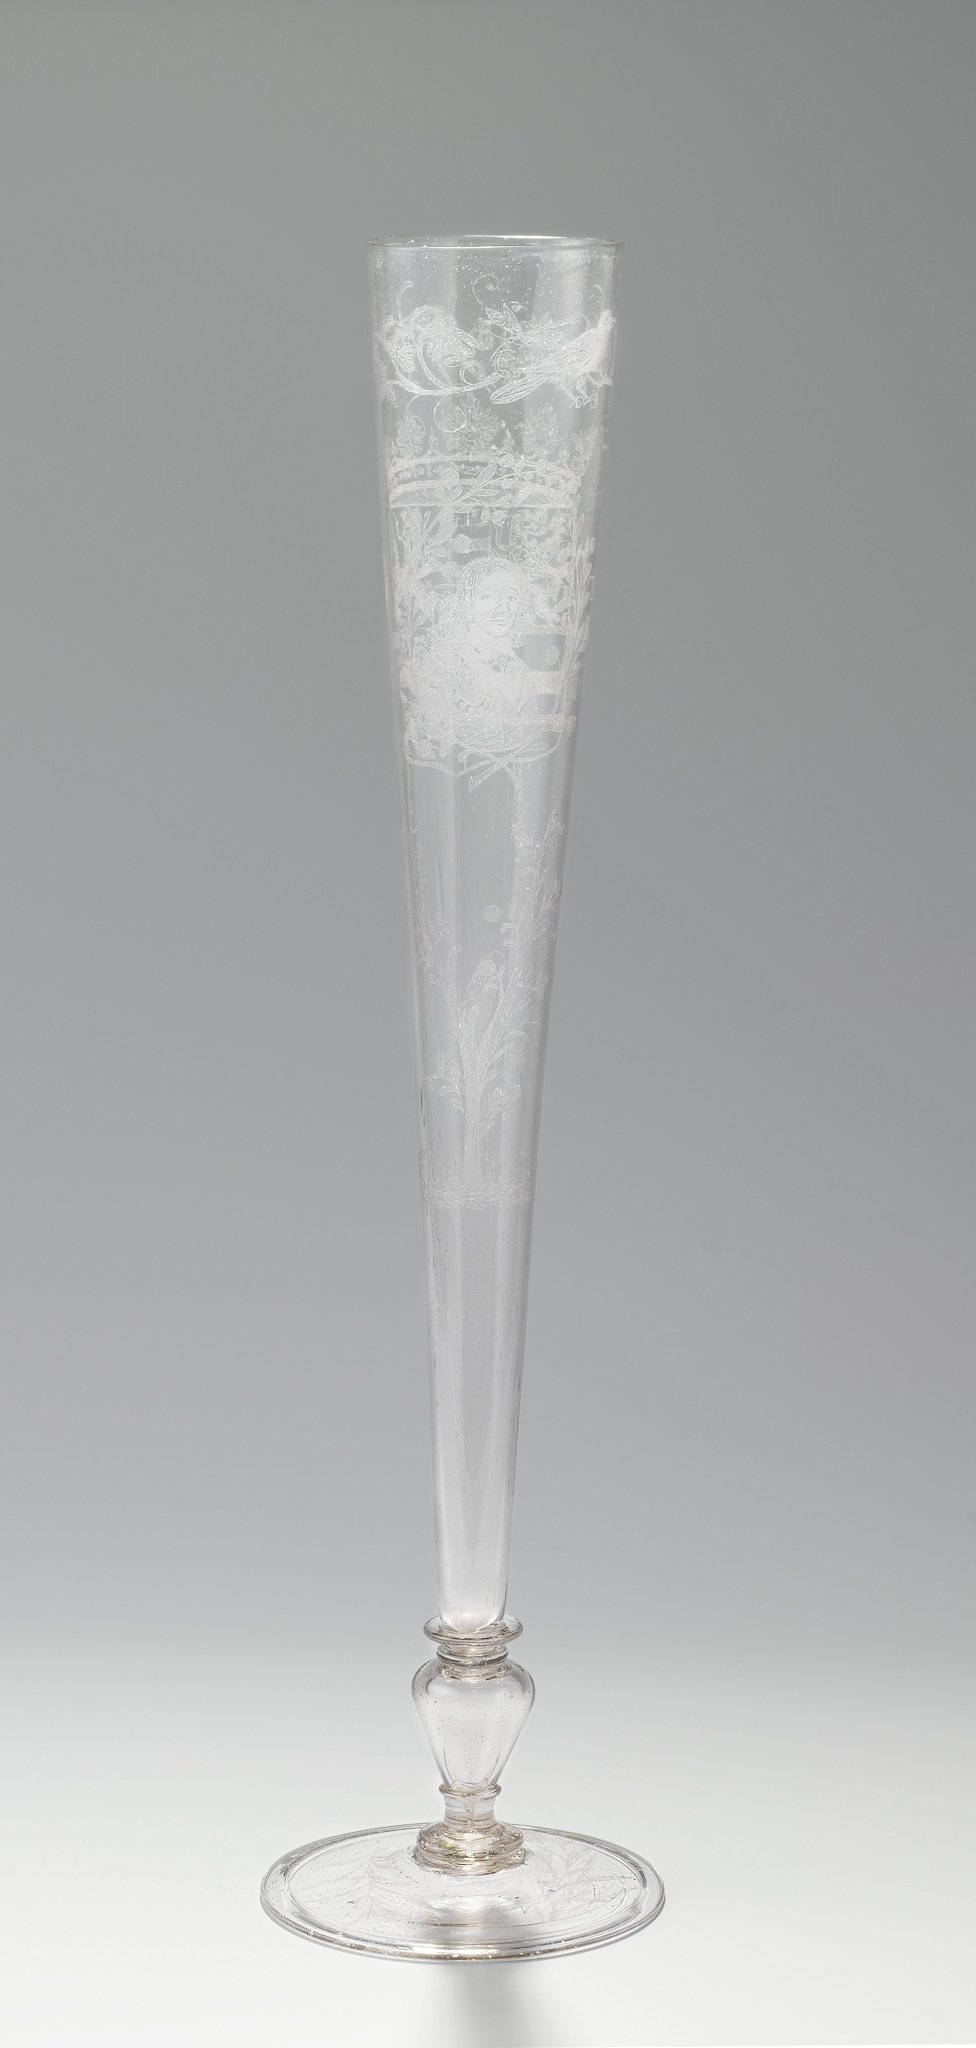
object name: flute glass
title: Flute glass with a portrait of William II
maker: Anonymous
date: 1650-1675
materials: glass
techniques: diamond point engraving, glassblowing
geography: low countries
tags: william ii (prince of orange), historical persons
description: In 1647 Prince William II succeeded his father Frederick Henry as stadtholder. The prince’s arms are engraved on the back of the glass.